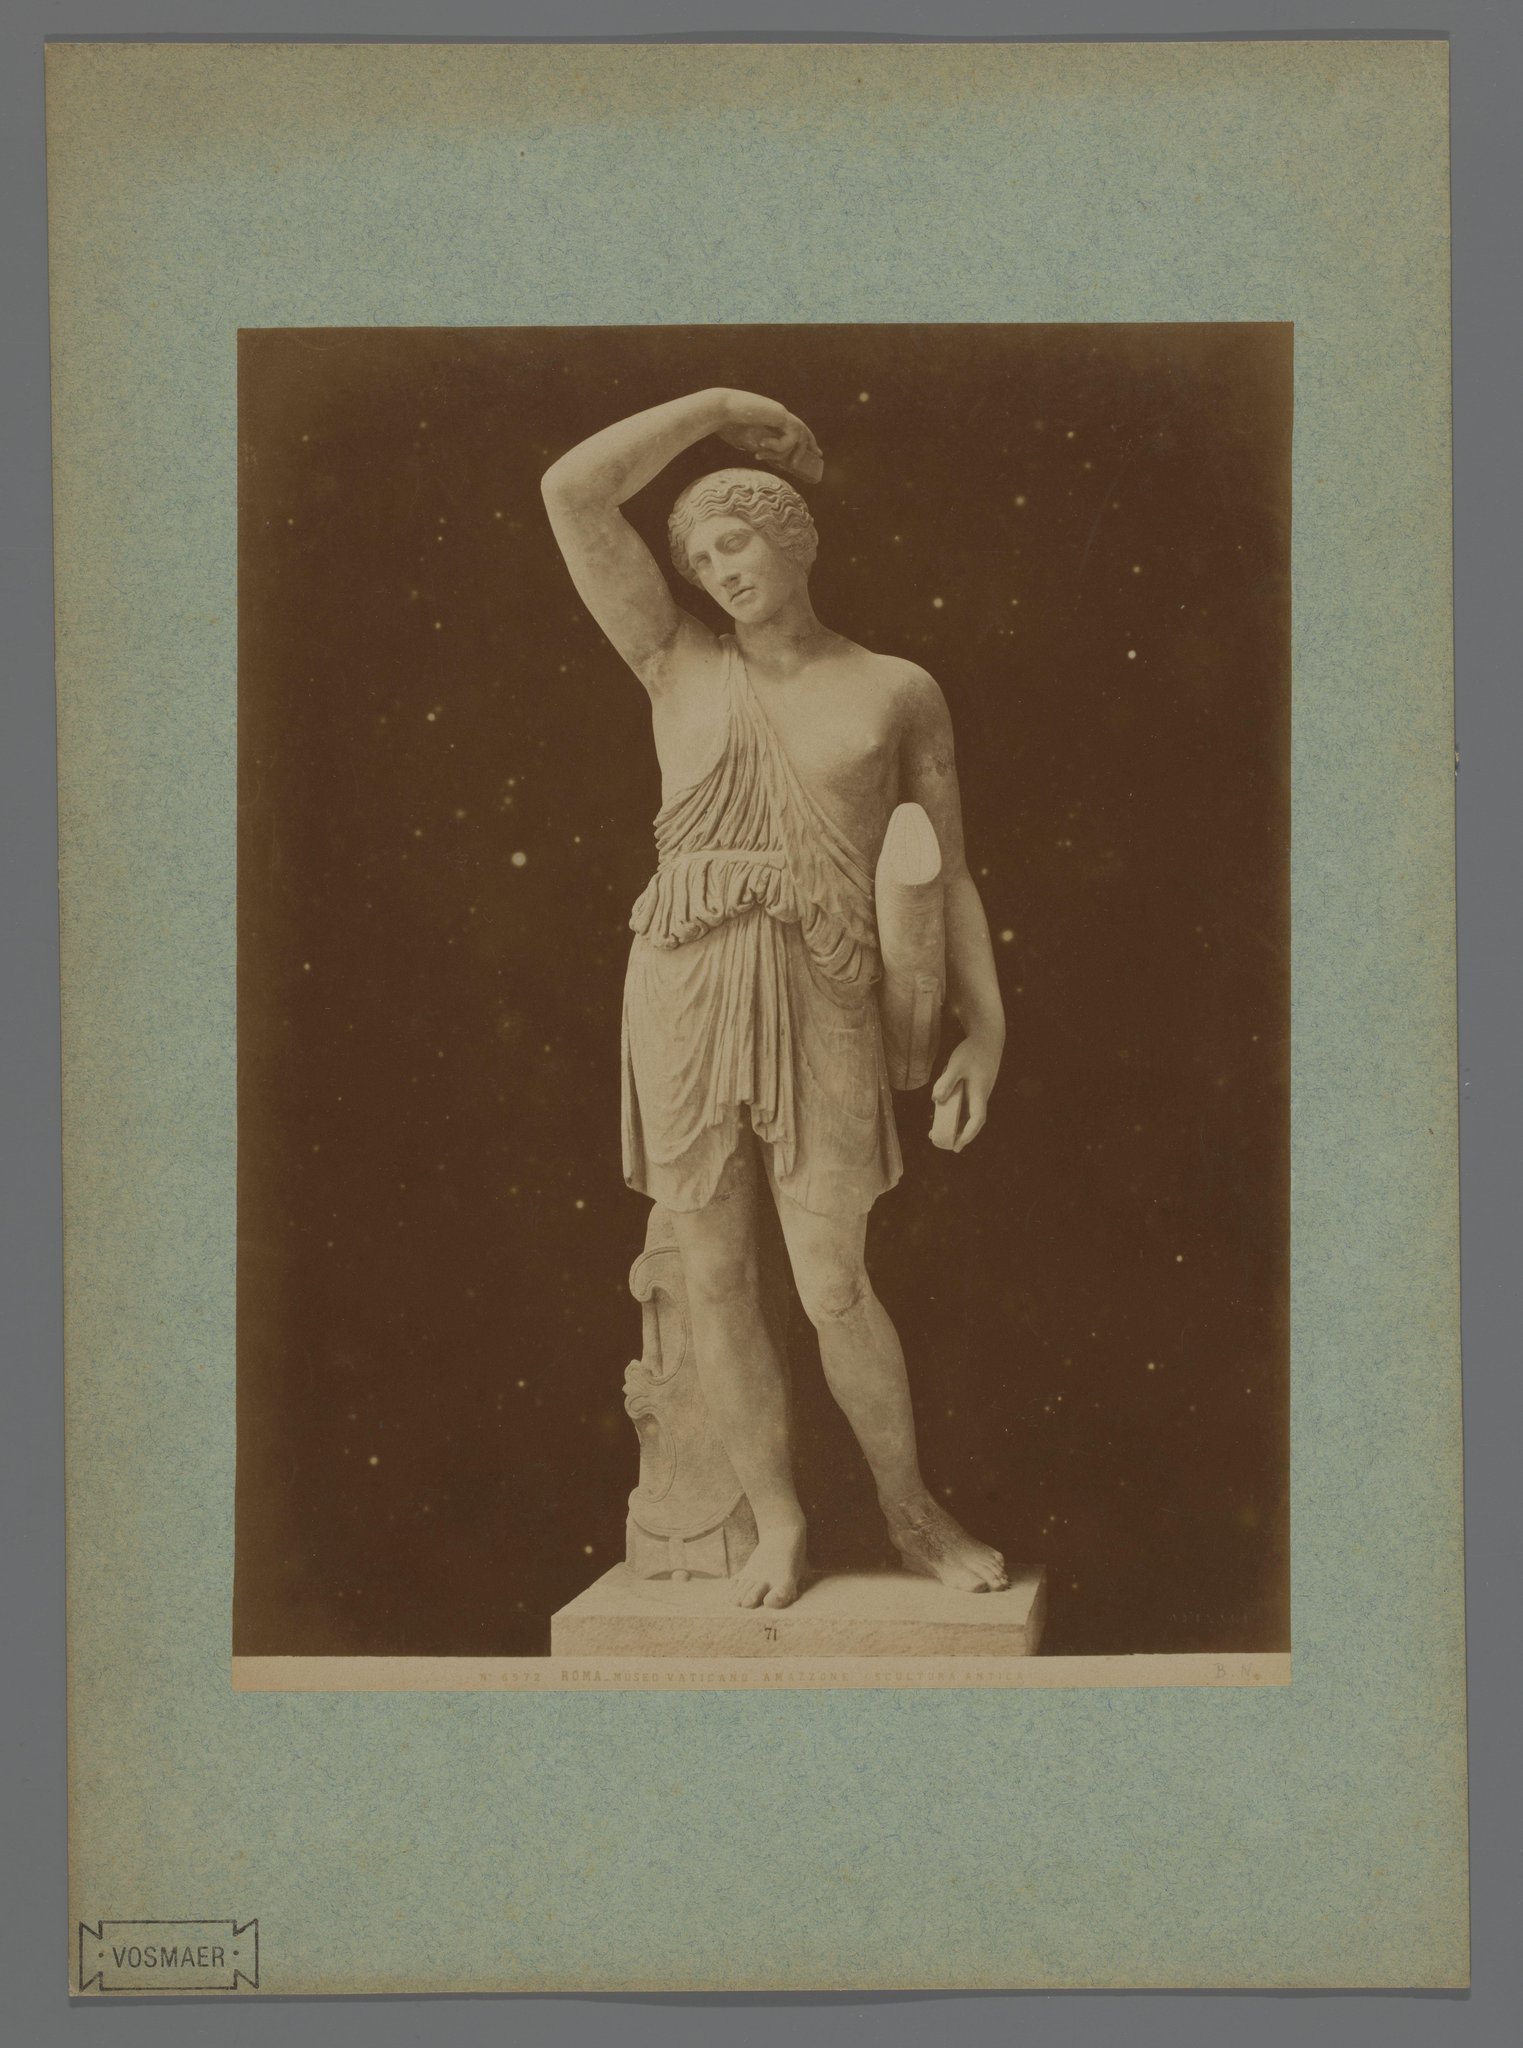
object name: photograph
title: Museo Vaticano. Amazzone. (Scultura Antica)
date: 1852-1900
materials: cardboard, paper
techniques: albumen print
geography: vatican city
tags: (story of) the amazons, piece of sculpture, reproduction of a piece of sculpture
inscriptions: inscription: ‘B.N.’, inscription: ‘doublet’, number: ‘No. 6572’, collector's mark: ‘VOSMAER’